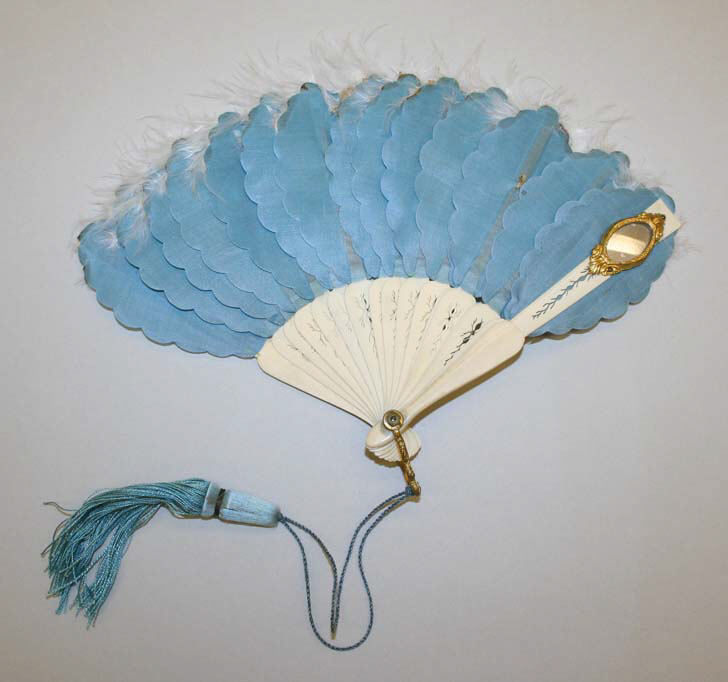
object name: brisé fan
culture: french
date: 1850-1859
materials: celluloid, silk